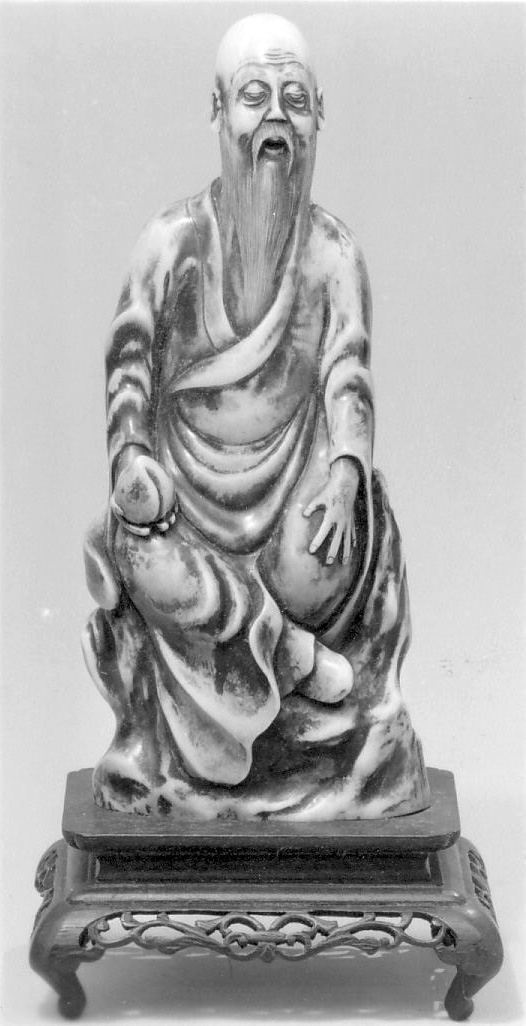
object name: statuette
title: Jurōjin, God of Longevity and Wisdom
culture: japanese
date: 1801-1900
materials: ivory, wood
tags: men